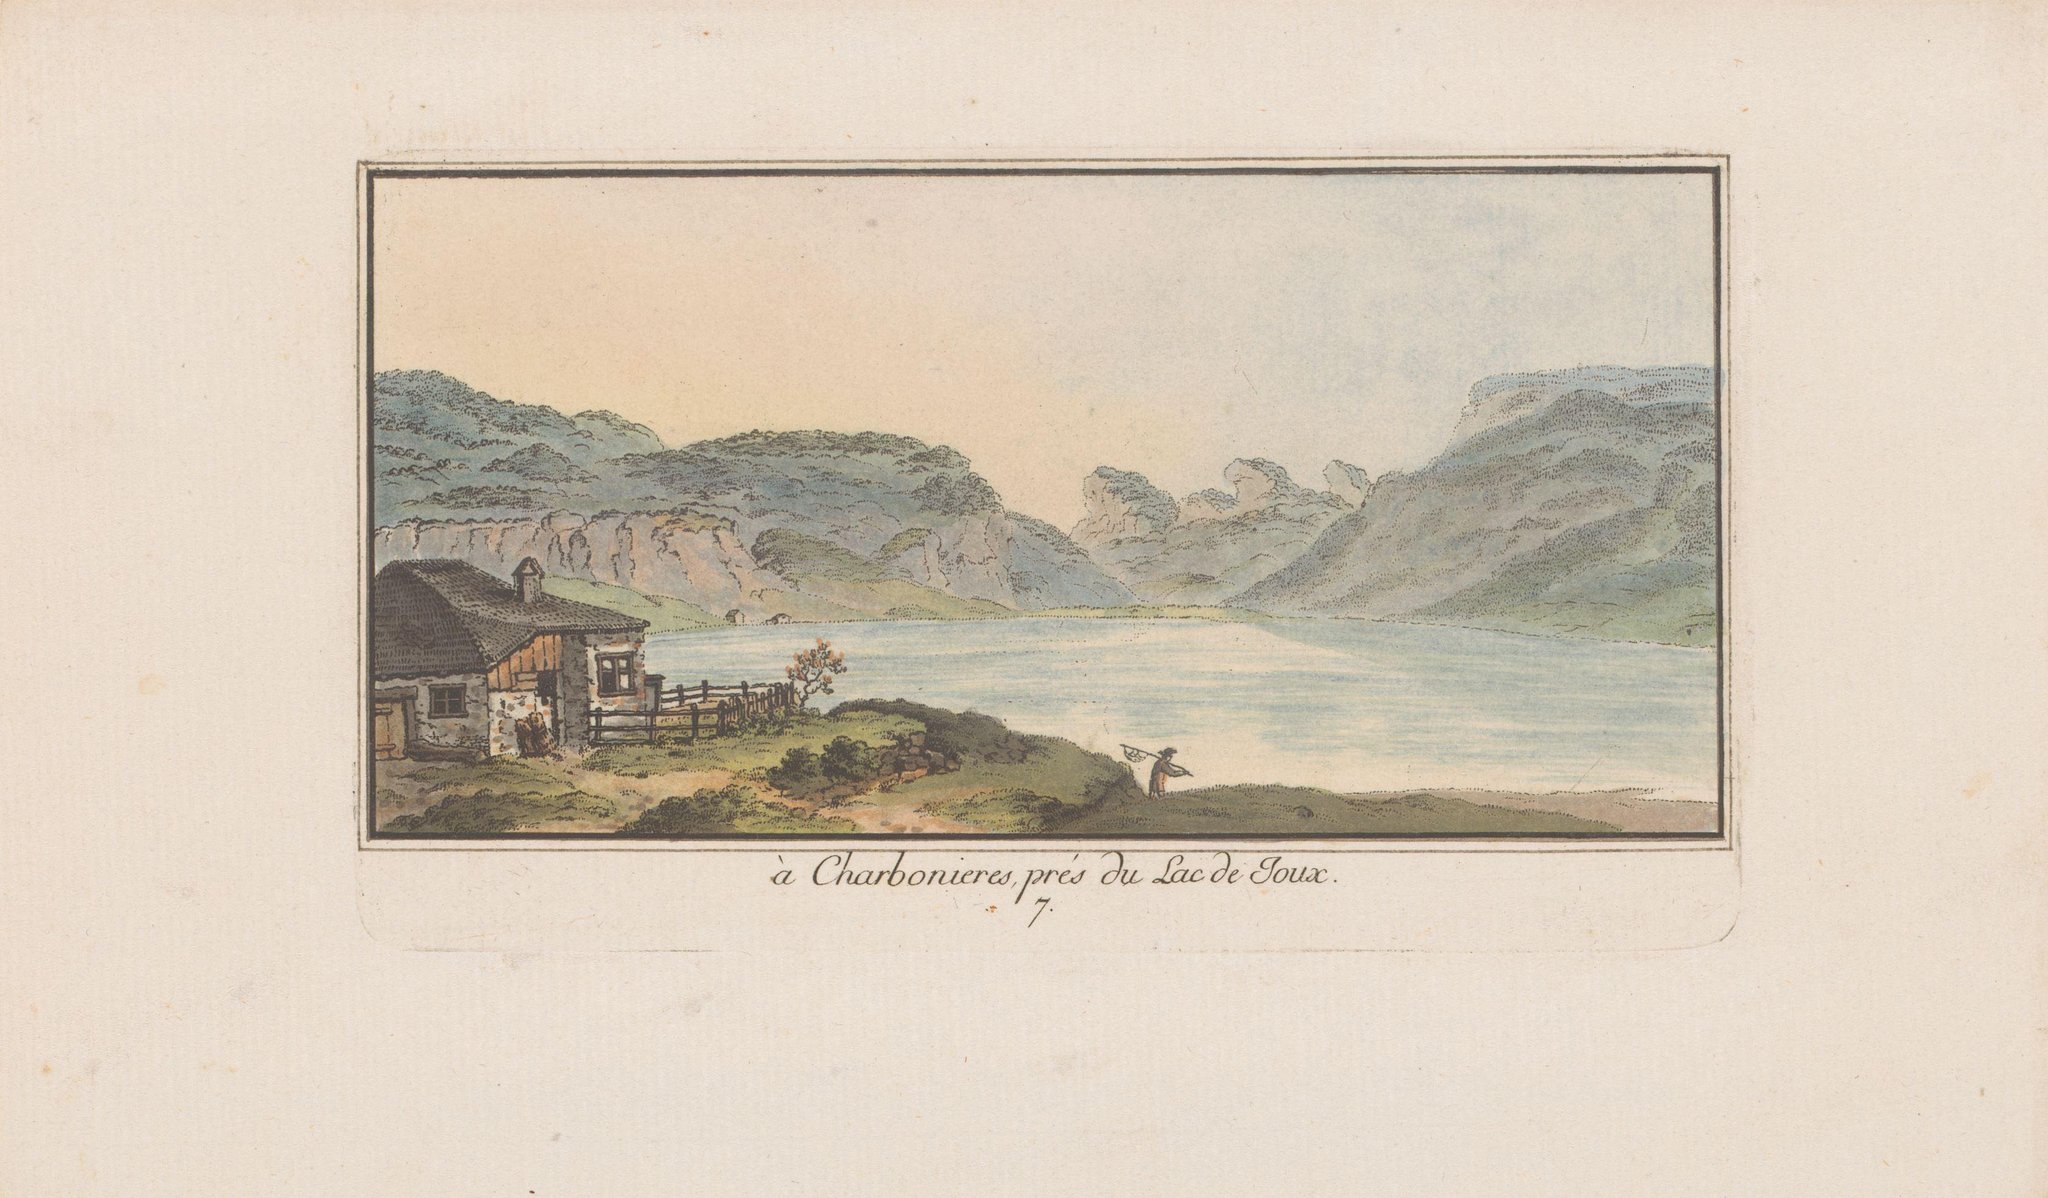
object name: print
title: à Charbonieres, près du Lac de Joux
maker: heinrich rieter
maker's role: print maker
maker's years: 1751-1818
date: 1782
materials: paper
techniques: etching, hand coloring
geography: bern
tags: landscapes, lake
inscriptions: collector's mark: Lugt 533b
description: De reeks is gebaseerd op een reis die beide kunstenaars samen maakten in 1782.